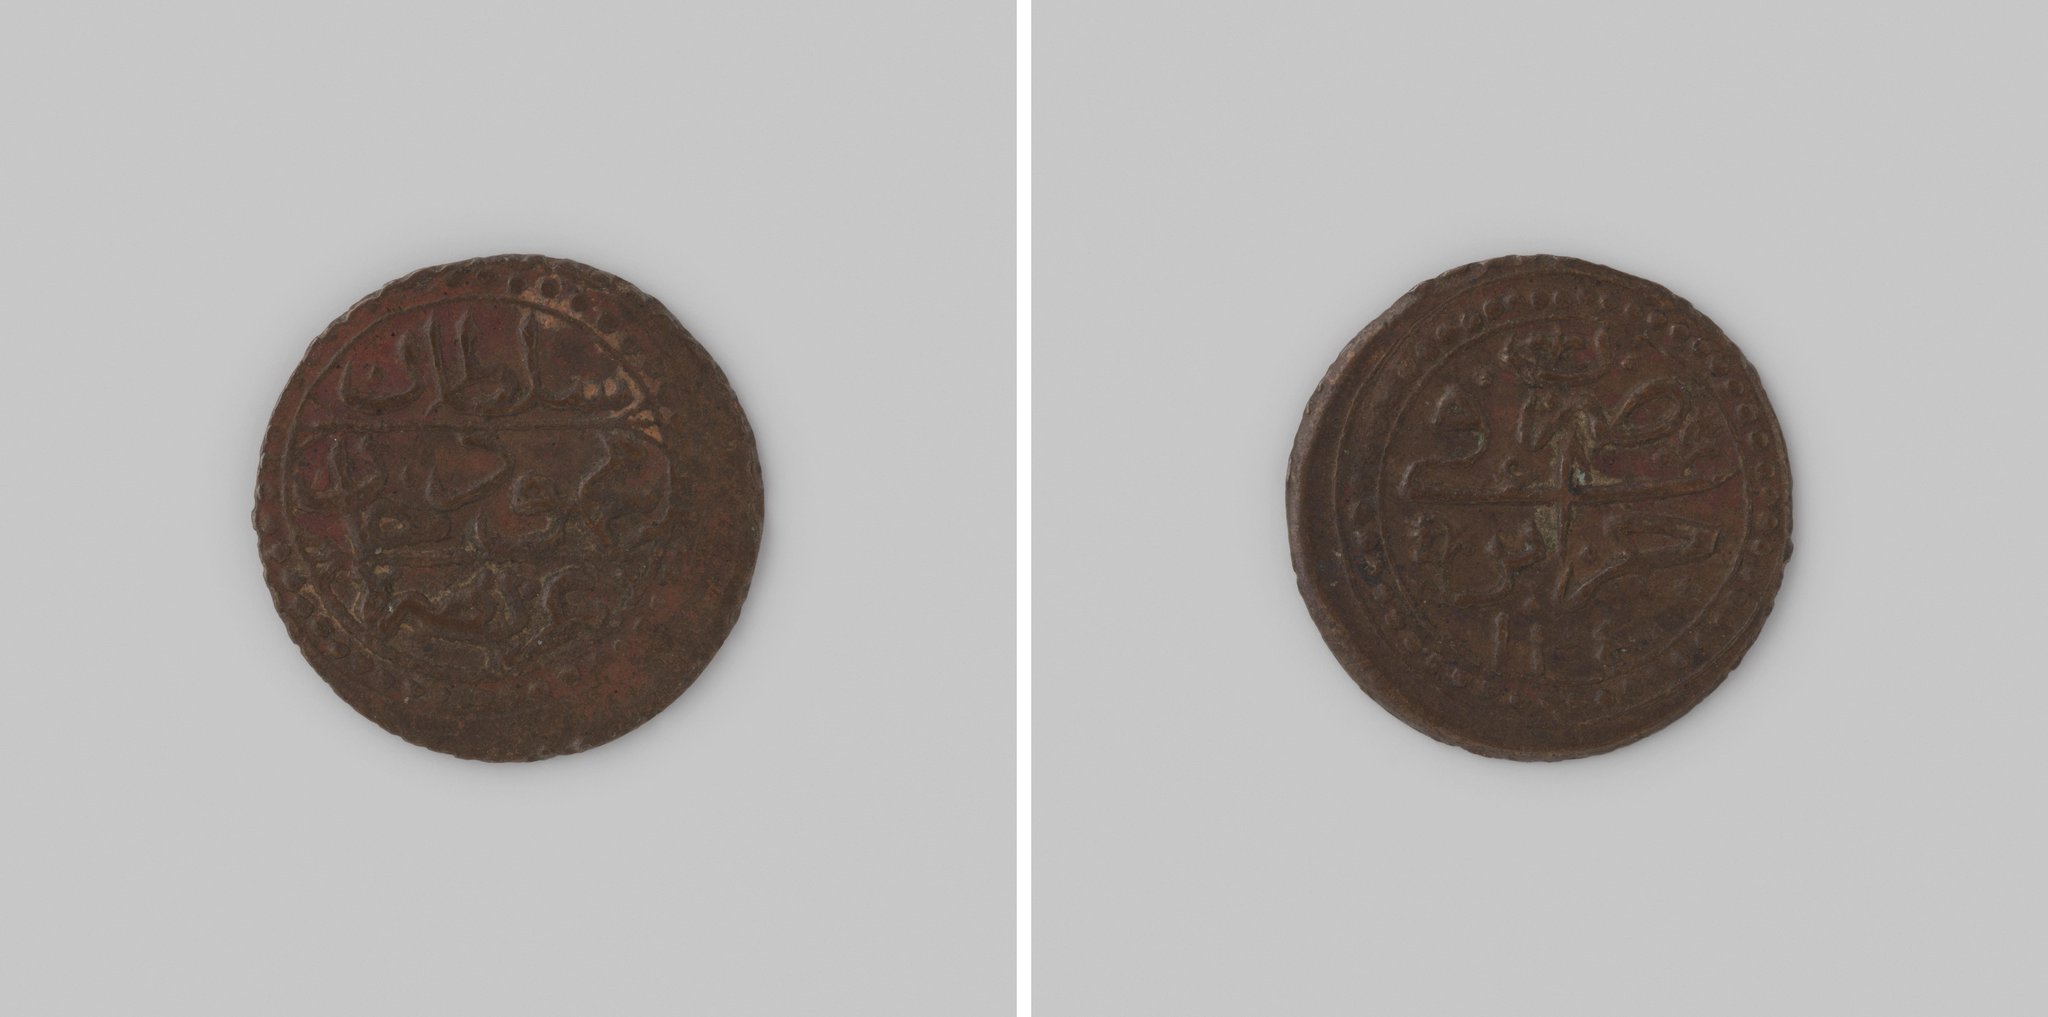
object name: coin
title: 5 asper uit Algerije van de Ottomaanse sultan Mahmud II, 1240[=1824]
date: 1824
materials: copper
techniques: striking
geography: algiers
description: Koperen munt. Voorzijde: vierregelig opschrift in Arabische letters, op eerste regel: sultan en op tweede regel de naam: Mahmud. Keerzijde: drieregelig opschrift in Arabische letters met muntplaats-aanduiding: Jaza ir [=Algiers]. Onderaan jaartal: 1240 [=1824]. Ruwe rand.